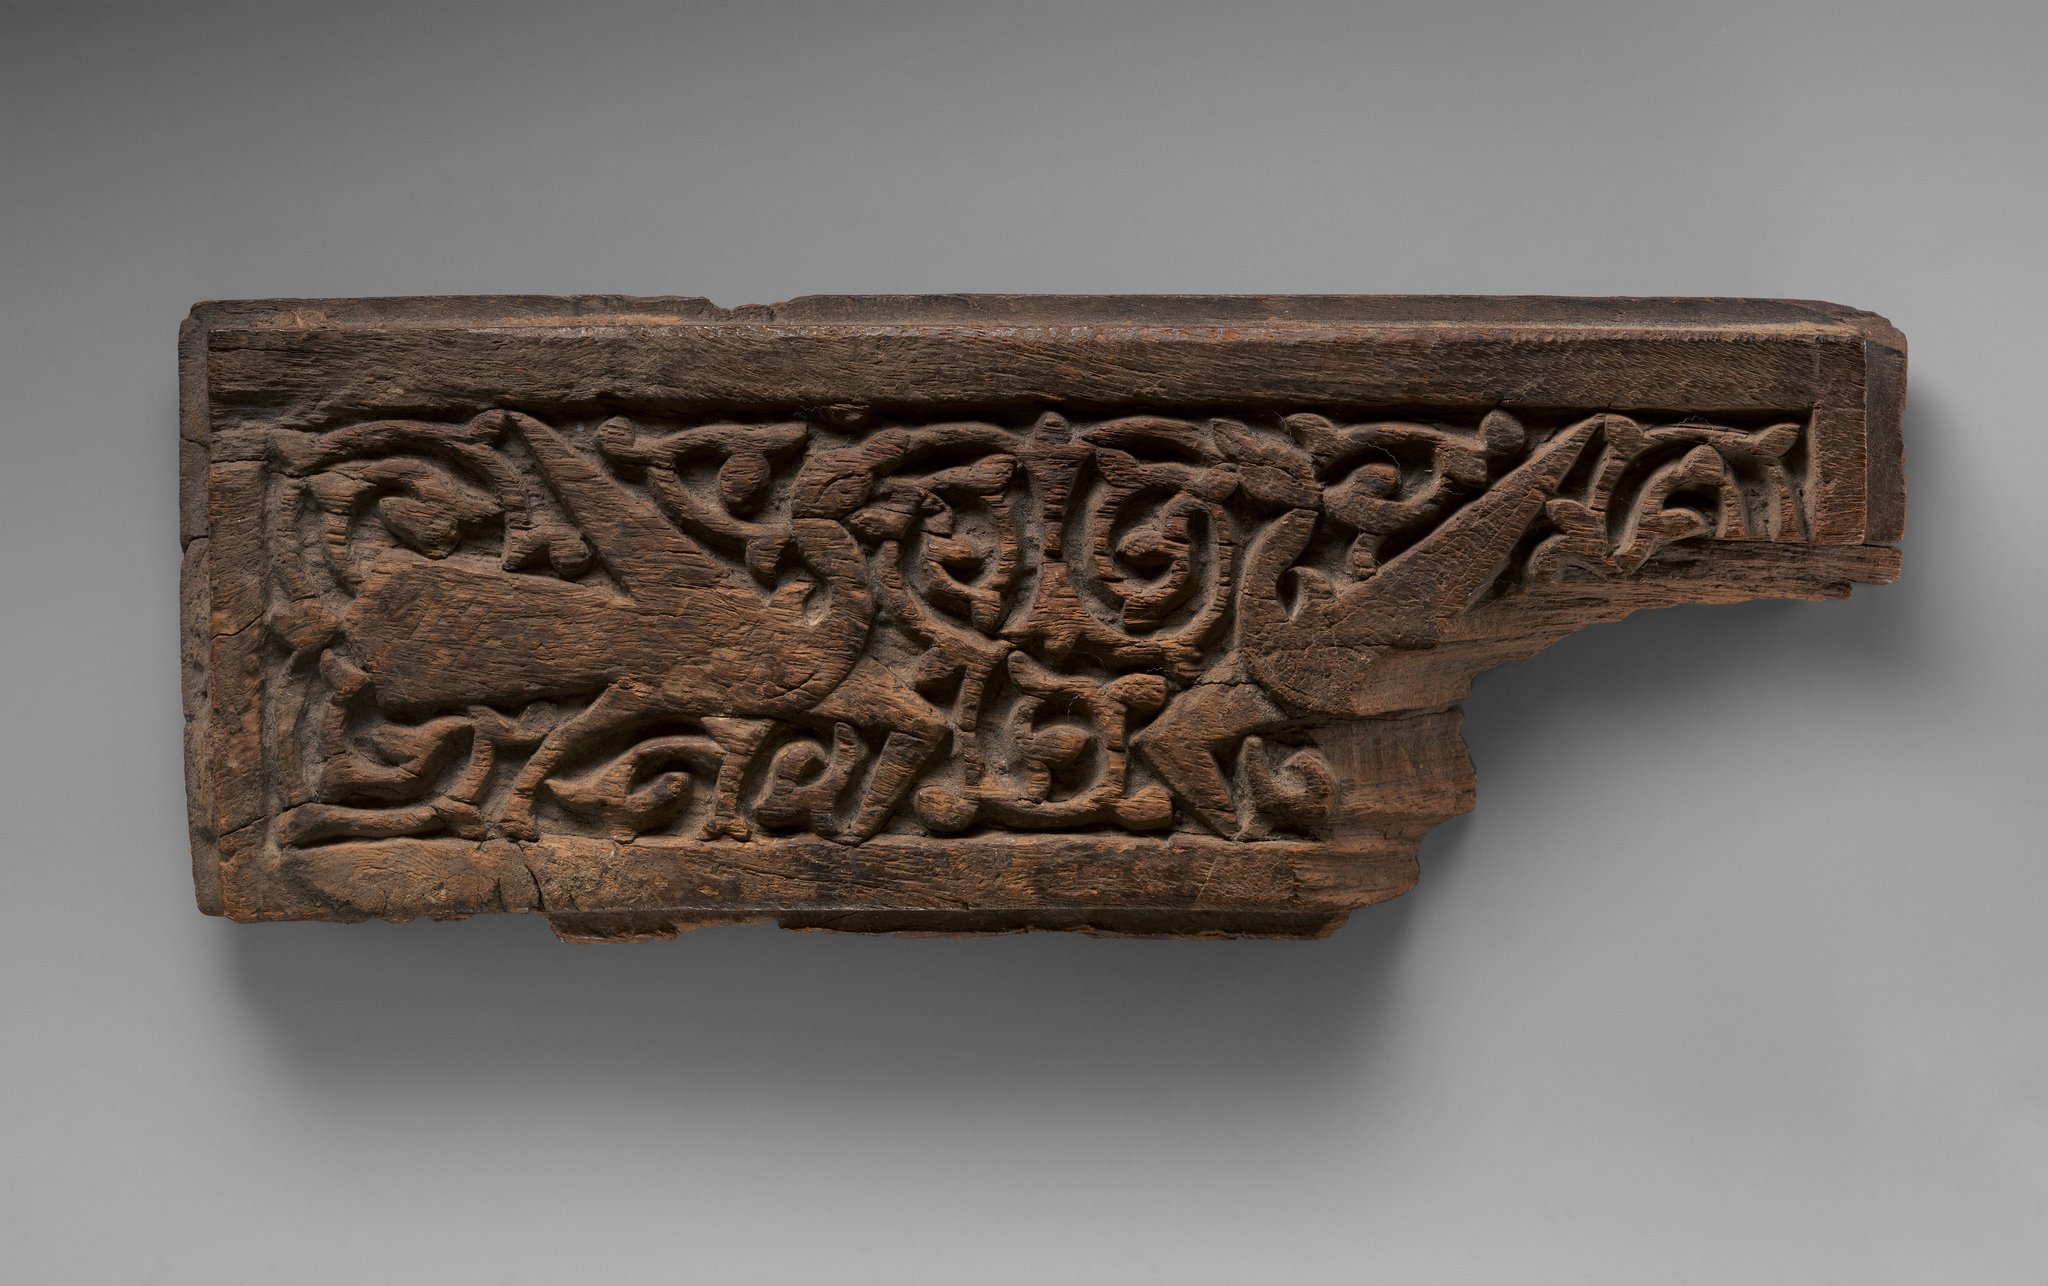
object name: wood fragment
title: Fragment of Carved Wood Panel with Two Birds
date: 1001-1200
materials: wood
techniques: carving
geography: egypt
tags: birds,architecture